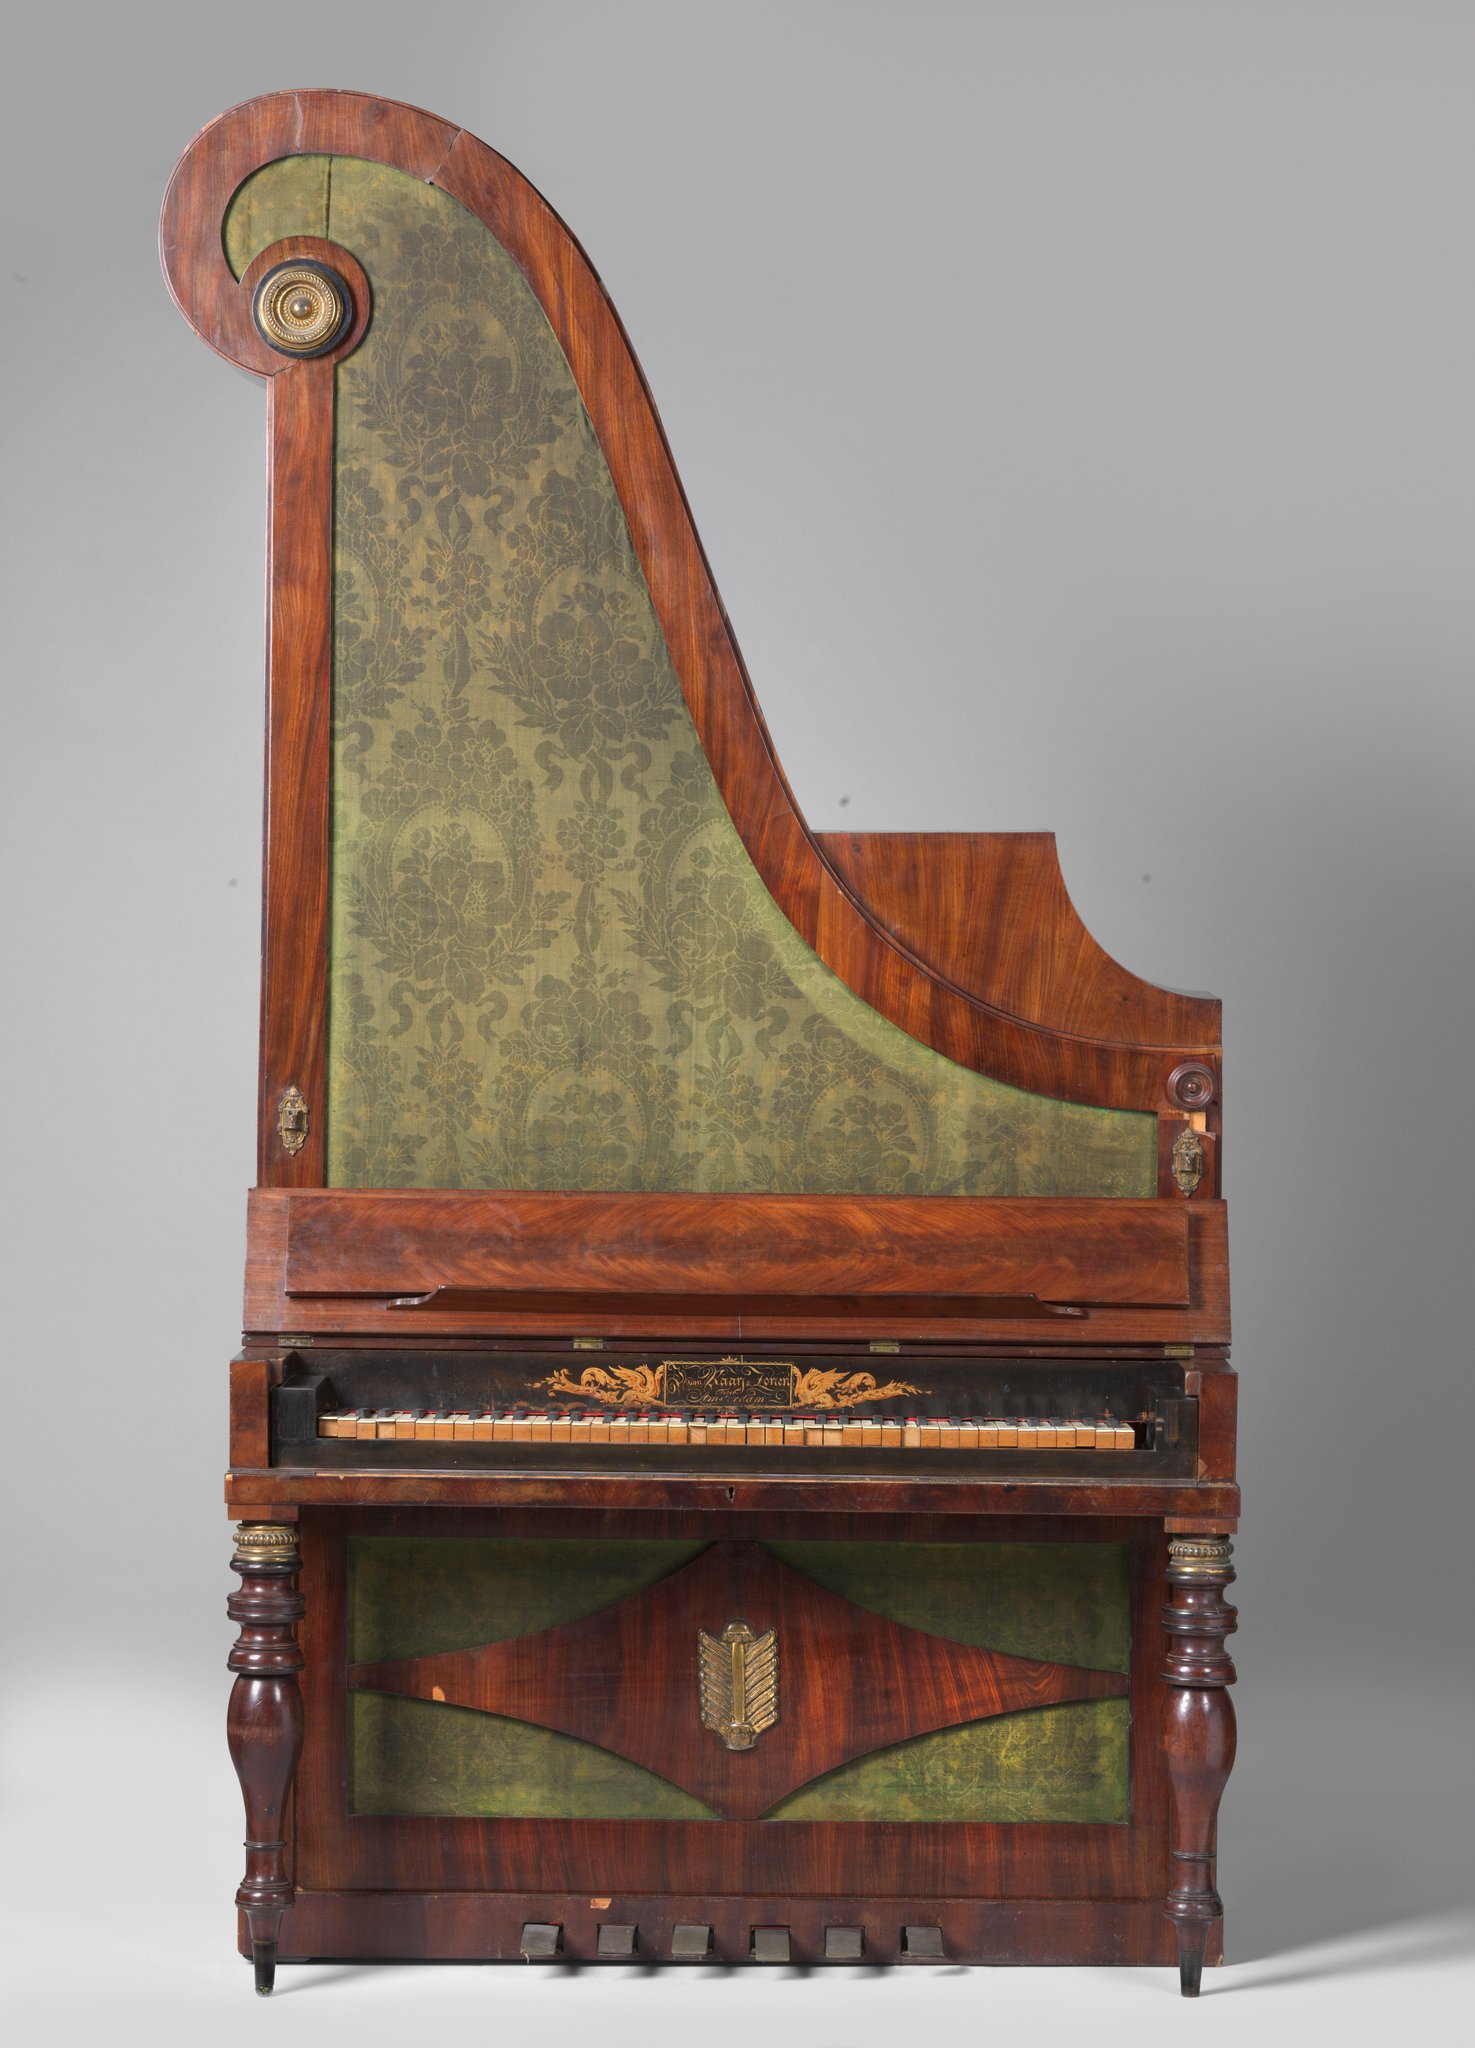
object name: pianoforte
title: Giraffe piano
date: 1830-1840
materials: copper, textile, wood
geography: amsterdam